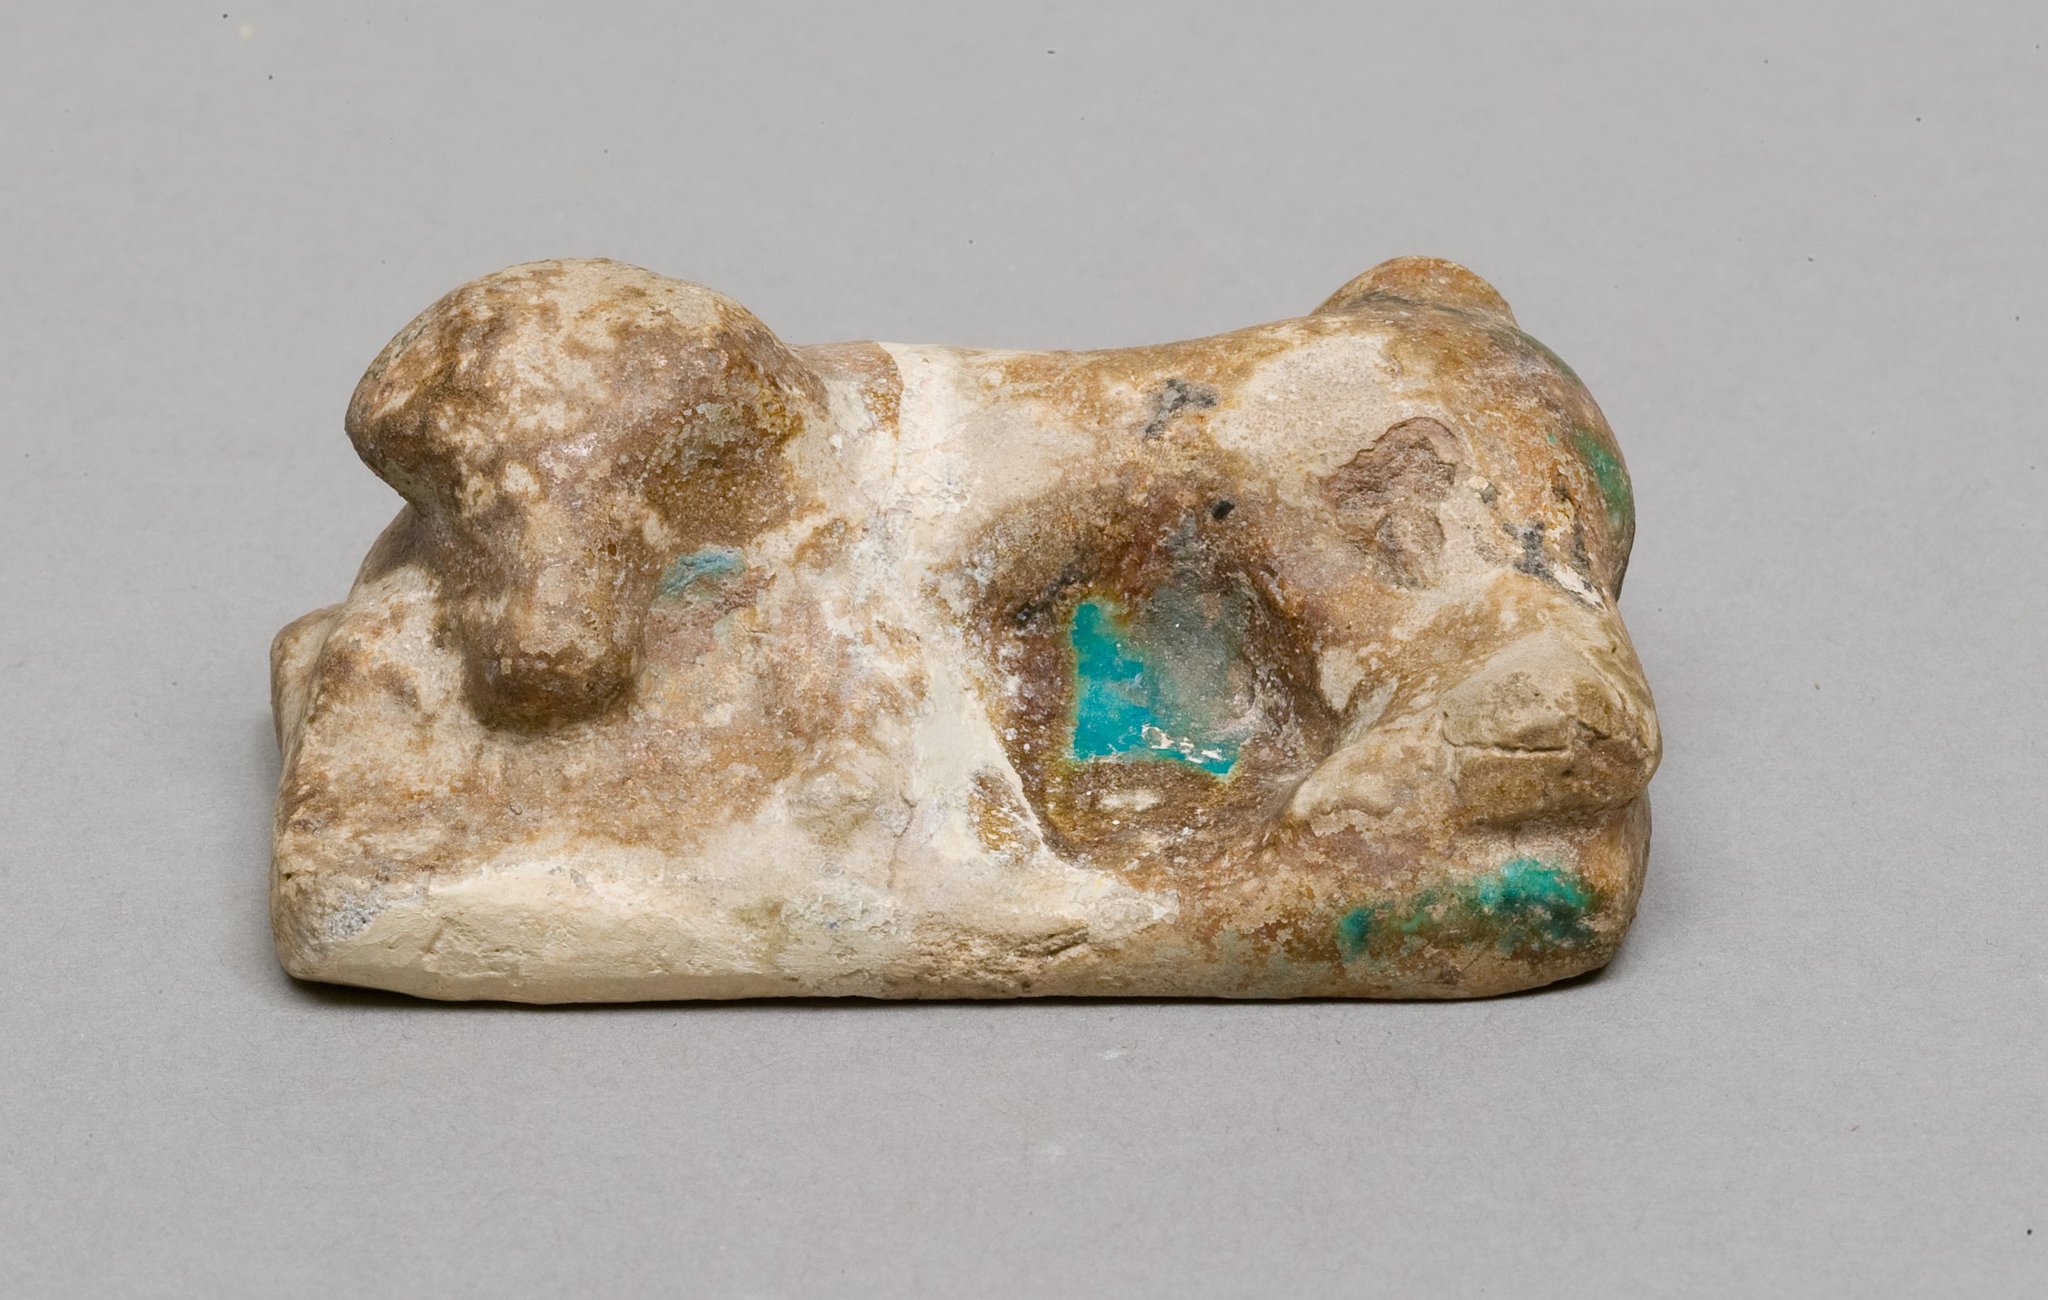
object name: figurine, animal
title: Dog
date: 1850-1700 BCE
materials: faience, glaze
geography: egypt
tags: dogs